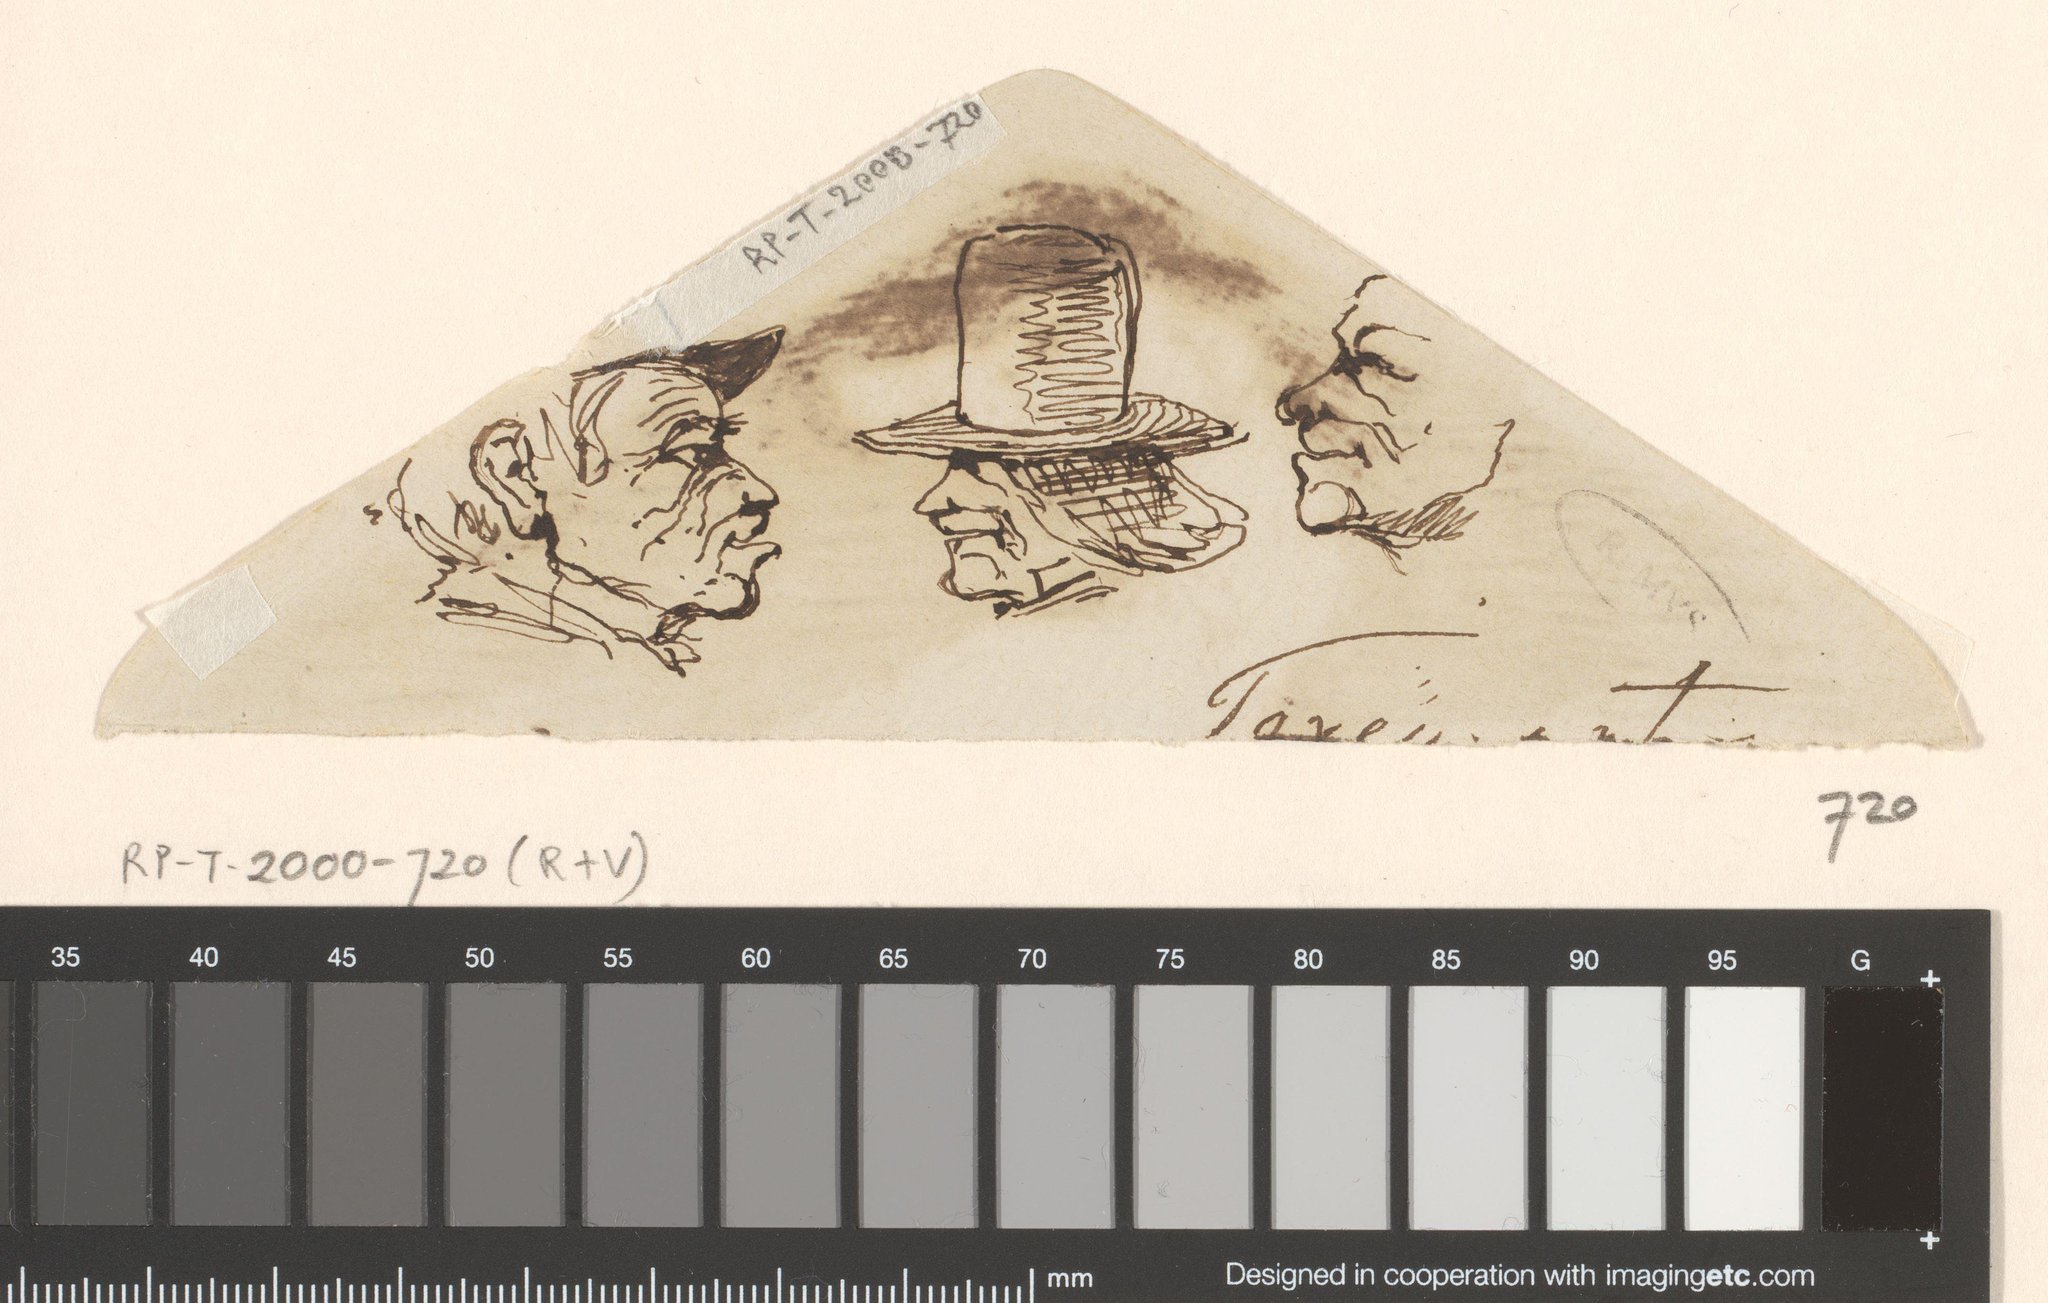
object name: drawing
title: Drie koppen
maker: johannes tavenraat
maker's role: draughtsman, painter, print maker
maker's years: 1809-1881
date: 1840-1880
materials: ink, paper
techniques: pen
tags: caricatures (human types)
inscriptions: collector's mark: Lugt 2228